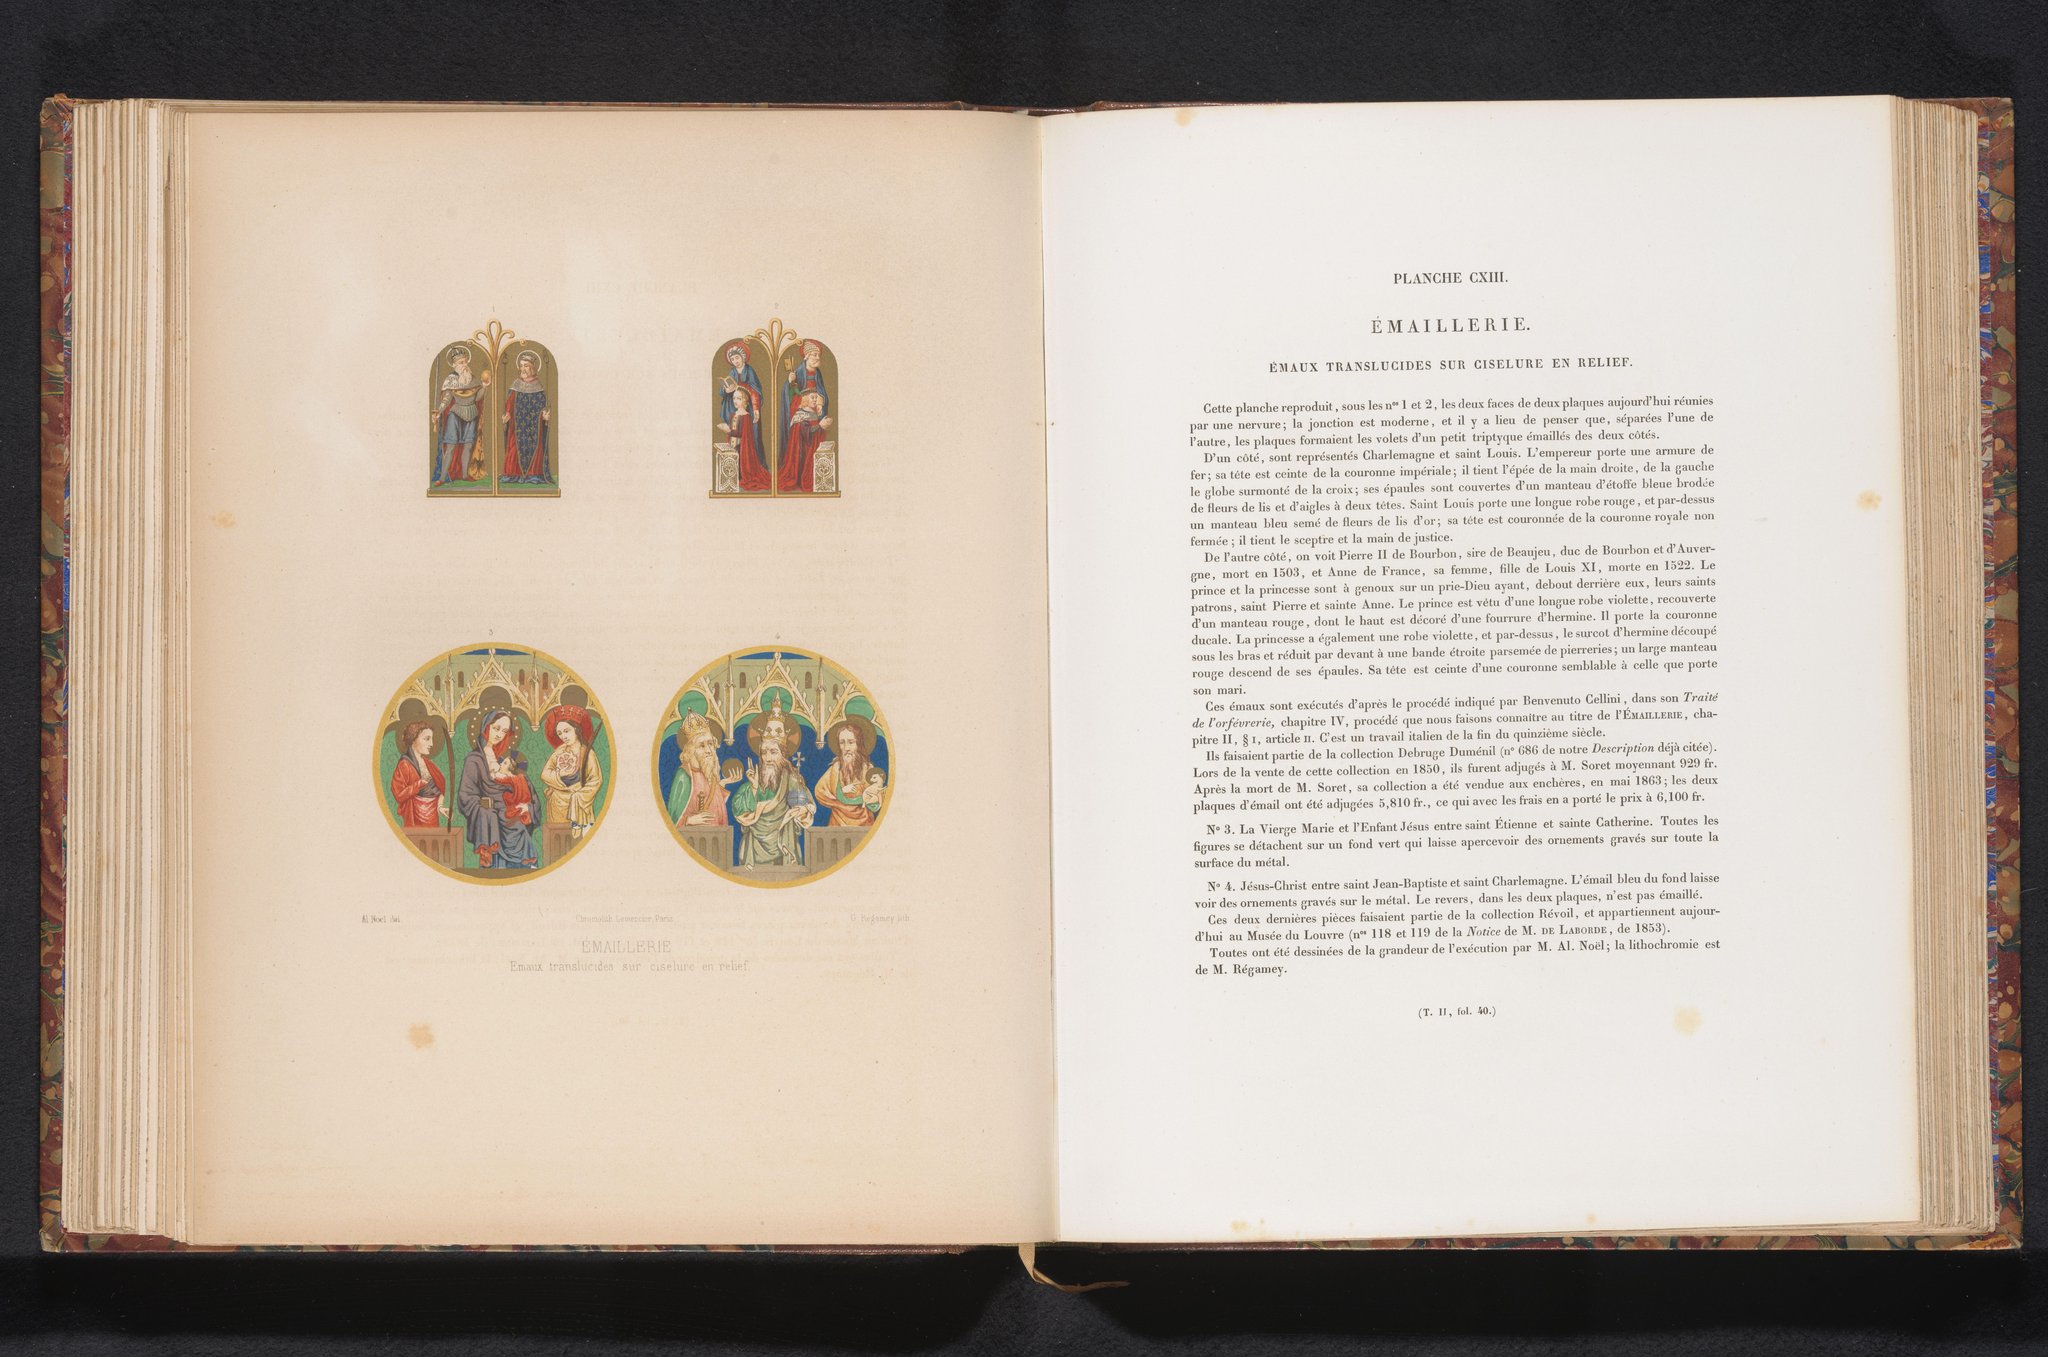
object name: reproduction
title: Emaux translucides sur ciselure en relief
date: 1859-1864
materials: paper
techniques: chromolithography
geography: paris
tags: madonna: i.e. mary with the christ-child, christ, series of scenes from the life of john the baptist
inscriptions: name: ‘Bosredon del./ Moulin lith.’